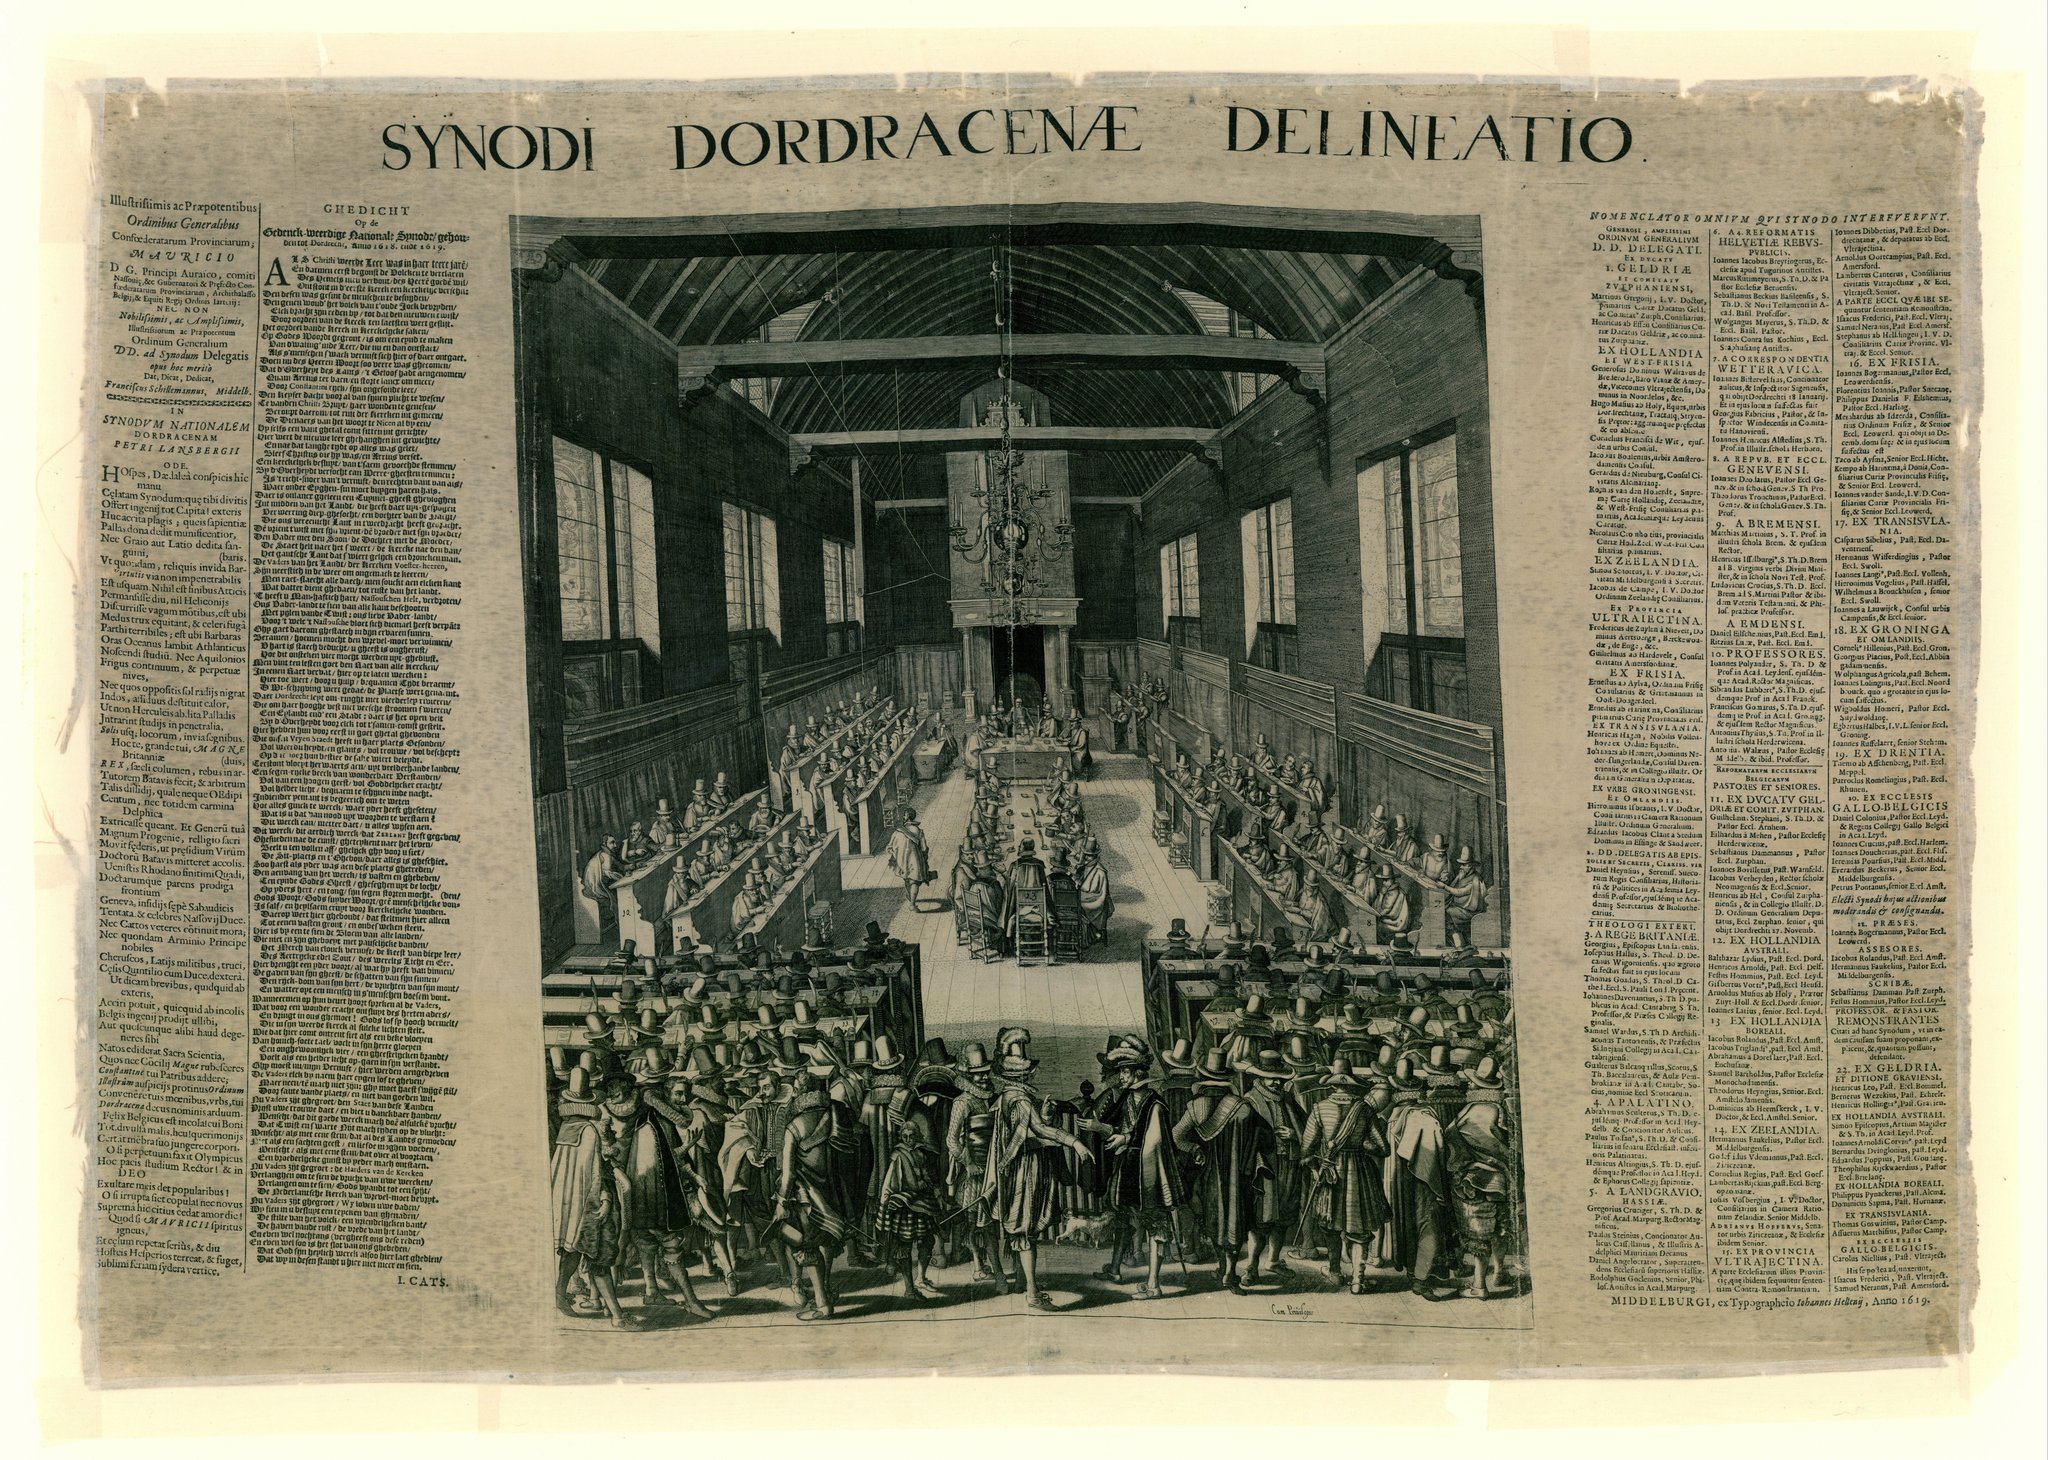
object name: print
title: Synodi Dordracenae delineatio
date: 1619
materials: silk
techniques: engraving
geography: northern netherlands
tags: organizations, assemblies, etc. in protestant churches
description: Grote plaat met een voorstelling van de opening van de nationale synode te Dordrecht op 13 november 1618 gedrukt op zijde. De voorstelling geeft een overzicht van de grote zaal met alle aanwezigen en toeschouwers. Elementen in de voorstelling zijn met cijfers aangeduid die in de legenda rechts worden verklaard. Links een Latijnse tekst en een gedicht van Cats getiteld 'Ghedicht op de Ghedenck-weerdighe Nationale Synode ghehouden tot Dordrecht, Anno 1618. ende 1619'.